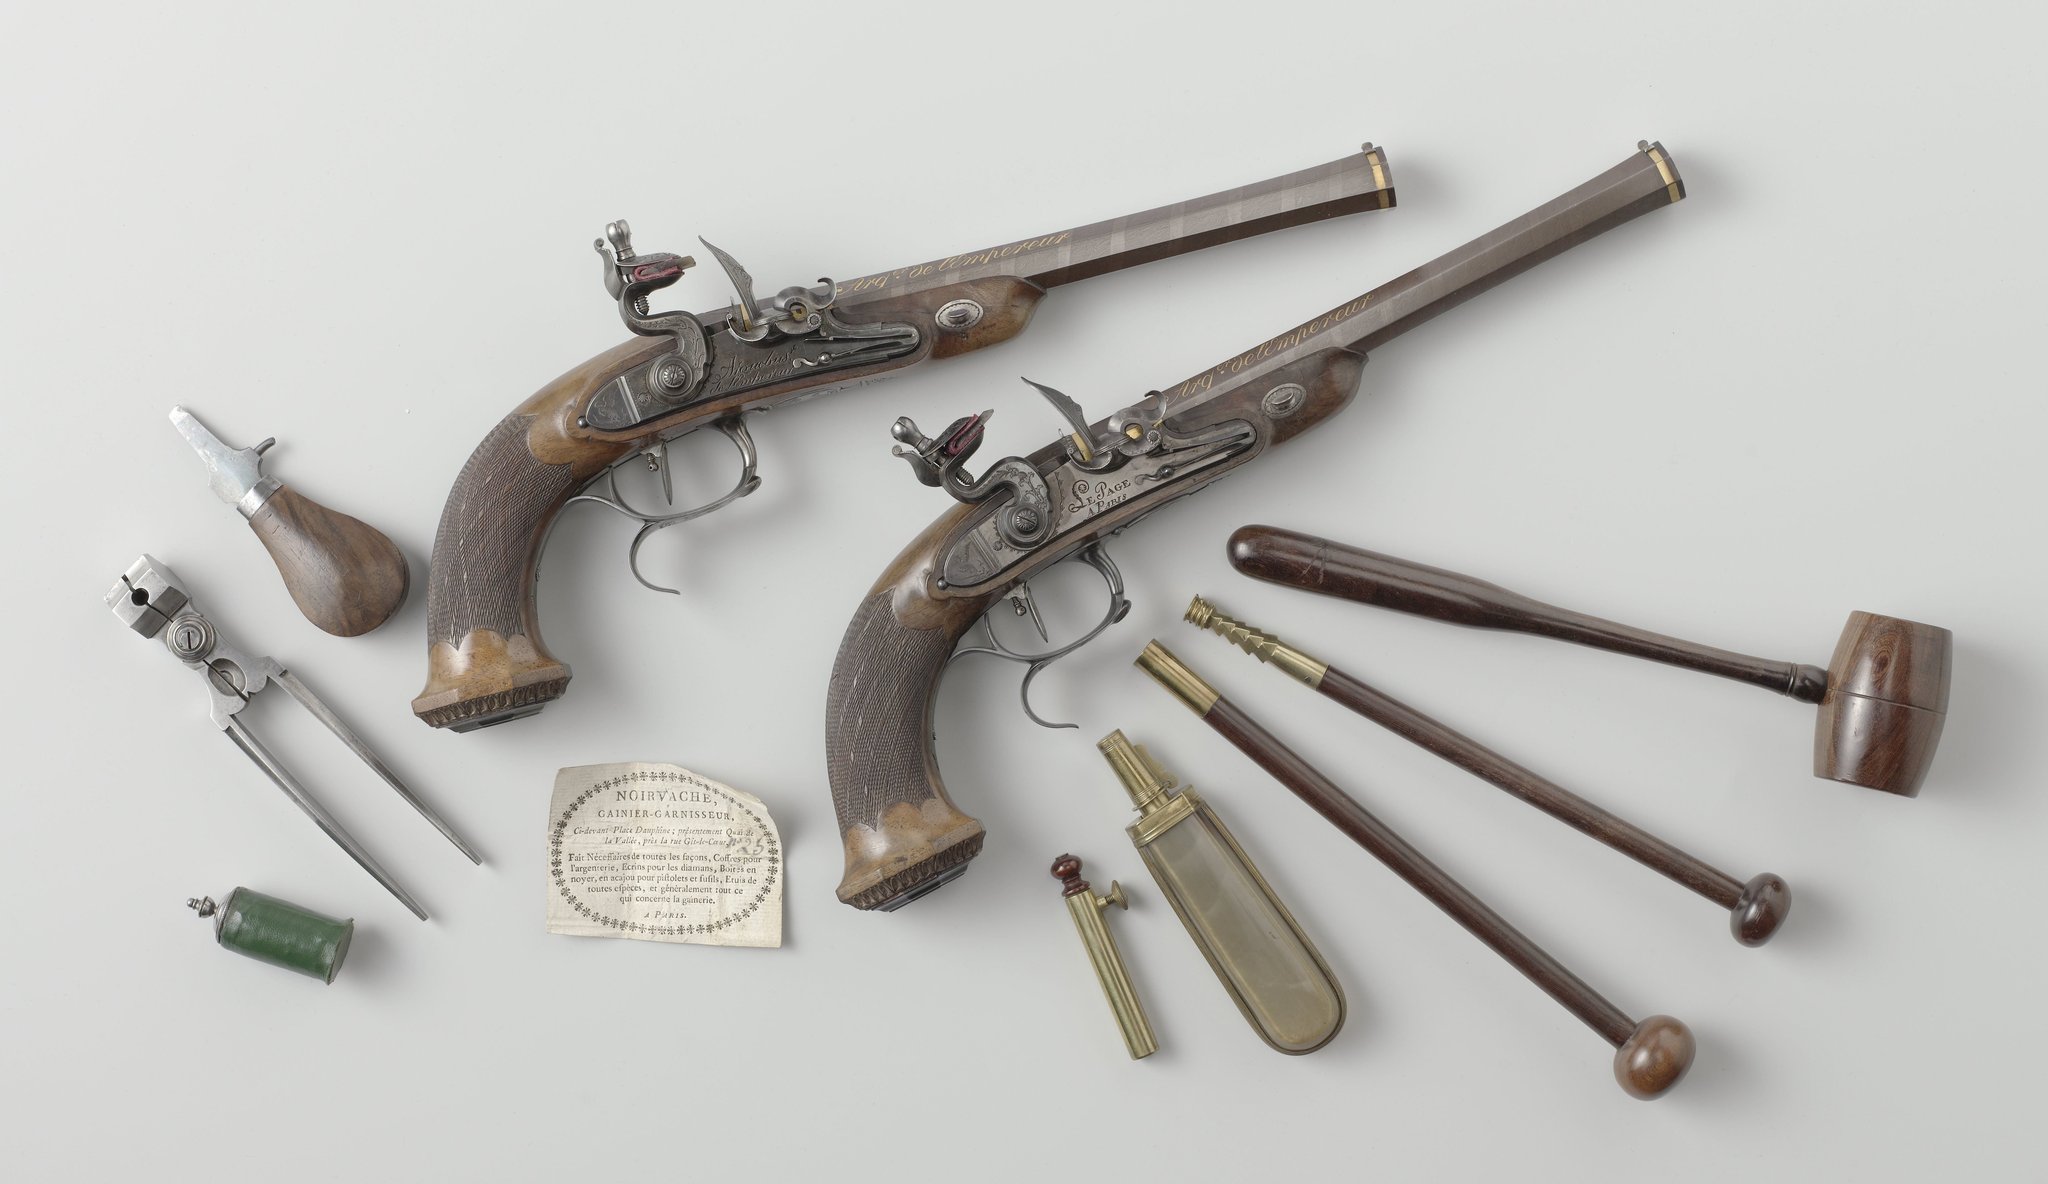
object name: gun accessory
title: Cassette voor koppel pistolen met toebehoren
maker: jean le page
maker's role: geweermaker, pistoolmaker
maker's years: 1746-1834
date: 1808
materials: brass, gold, leather, wood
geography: paris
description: Cassette: Gepolitoerde mahoniehouten kist, met aan de bovenkant een handvat van messing, aan de voorkant een ruitvormig sleutelgatplaatje van messing. Smeedijzeren sleutel. Het deksel is aan de binnenzijde bekleed met groen safraanleder, waarop randmotieven in goud stempeling. De bergruimte is bekleed met rood leder en in speciaal hiervoor uitgespaarde ruimten, bevinden zich twee pistolen en toebehoren.